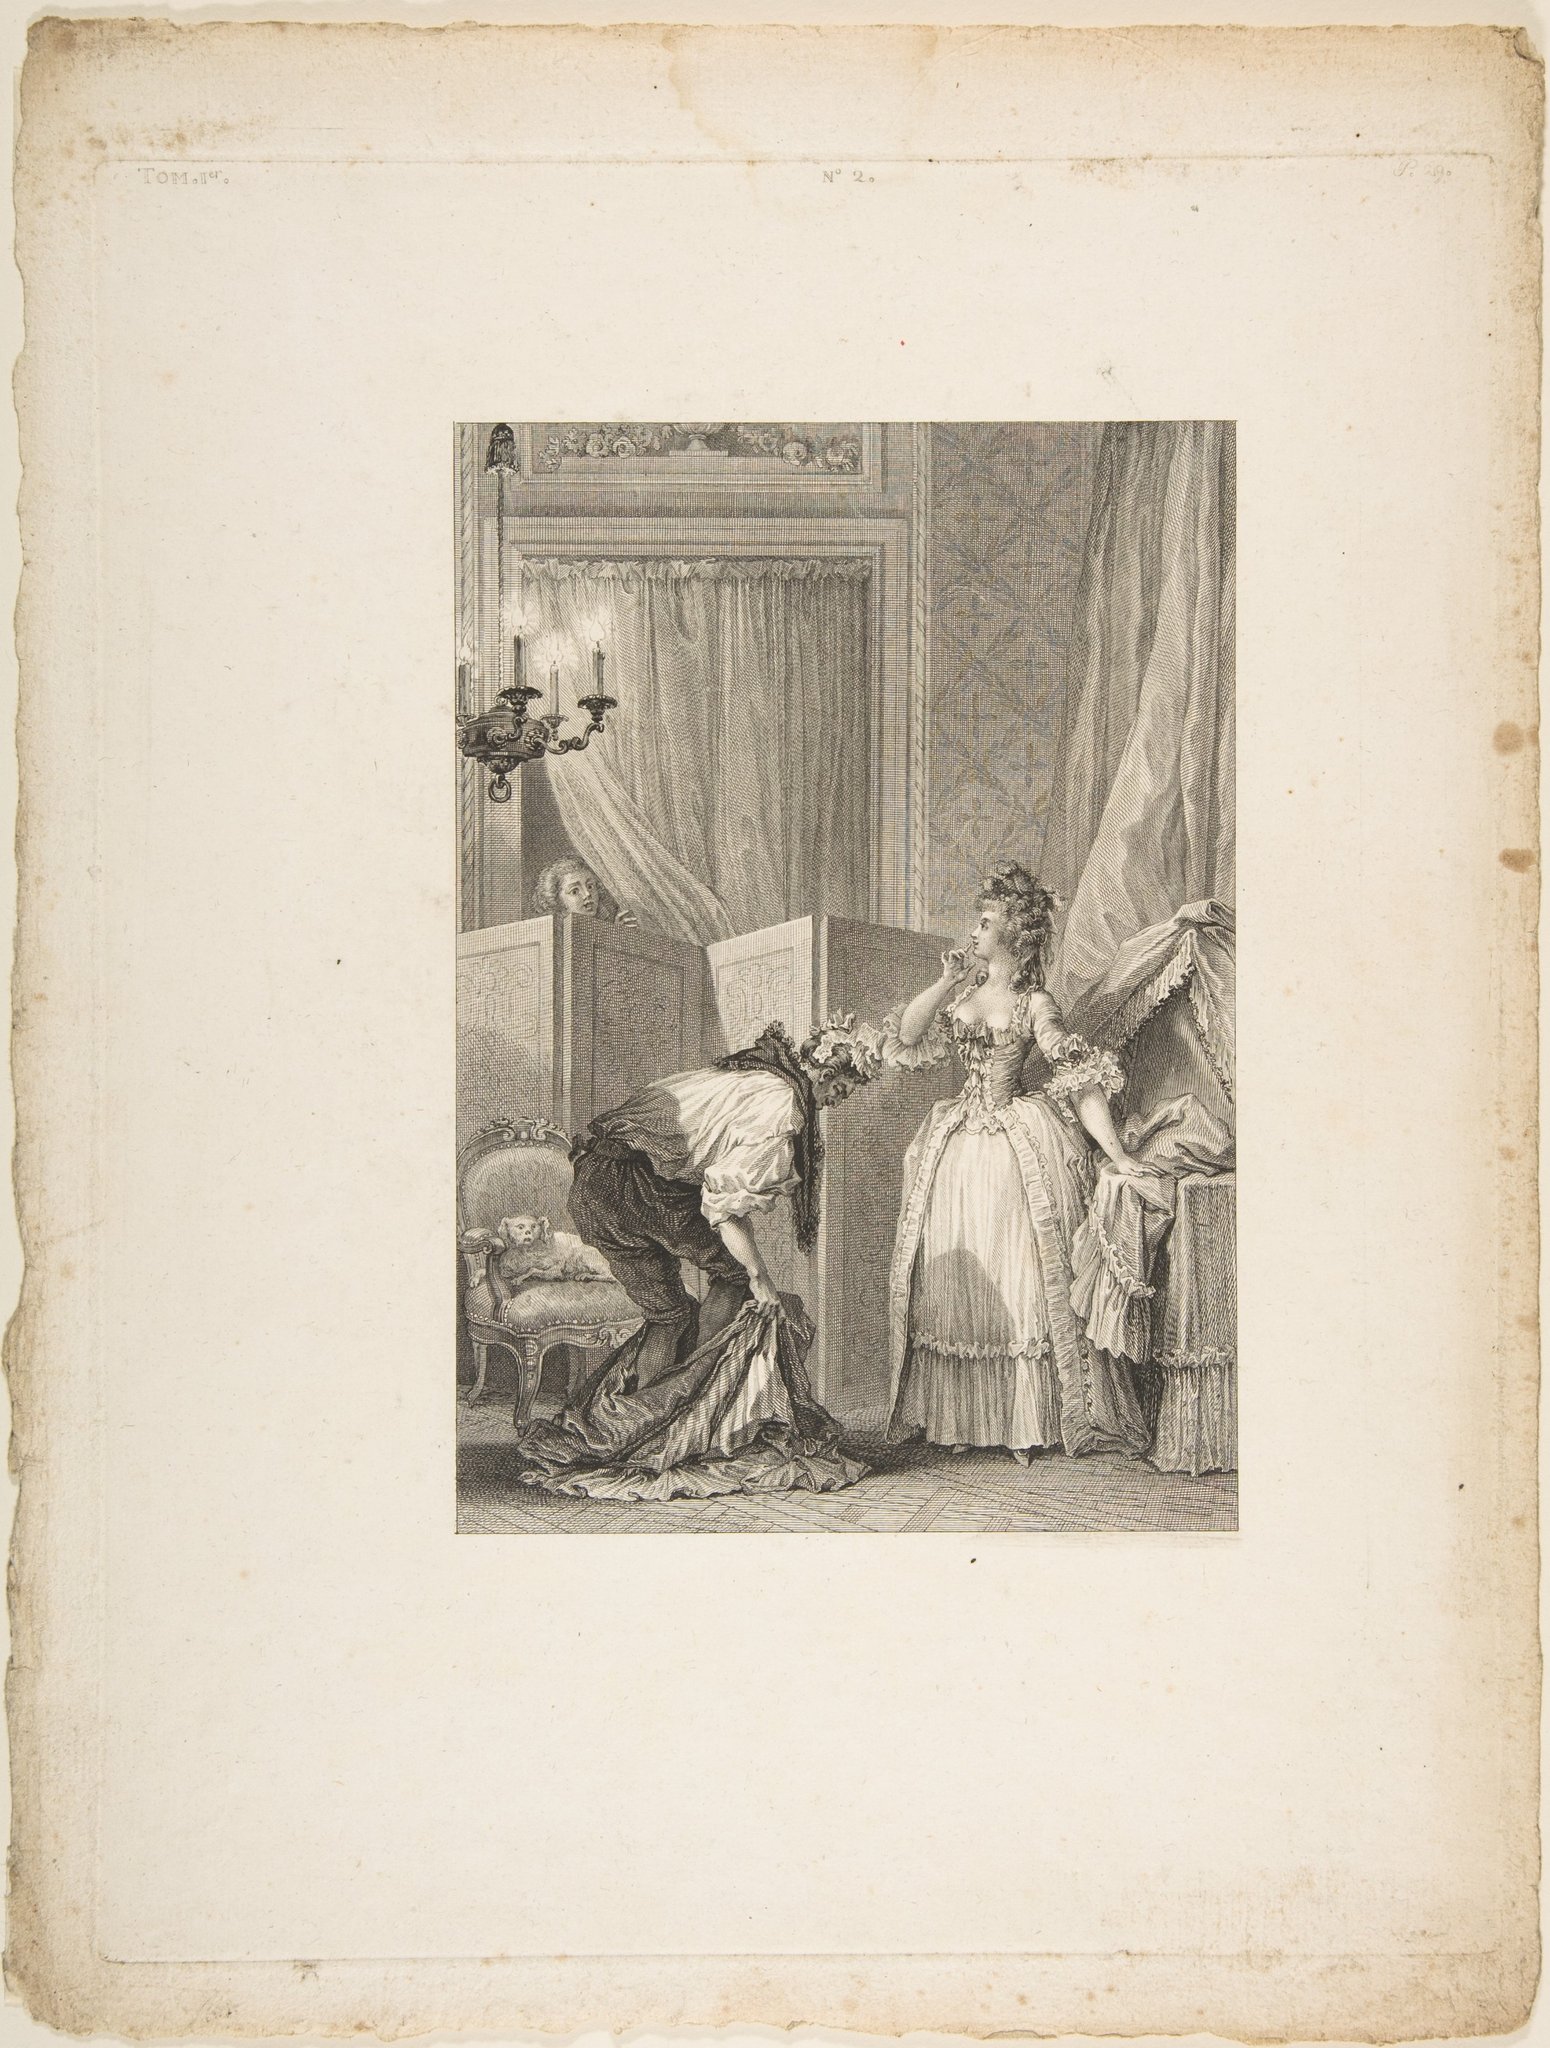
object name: print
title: Le Cocu battu et content, from "Contes et nouvelles en vers par Jean de La Fontaine. A Paris, de l'imprimerie de P. Didot, l'an III de la République, 1795"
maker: jean-louis delignon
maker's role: artist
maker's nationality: french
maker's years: 1755-1804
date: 1795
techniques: engraving, etching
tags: bedrooms,women,dogs,dressing,screens,chairs